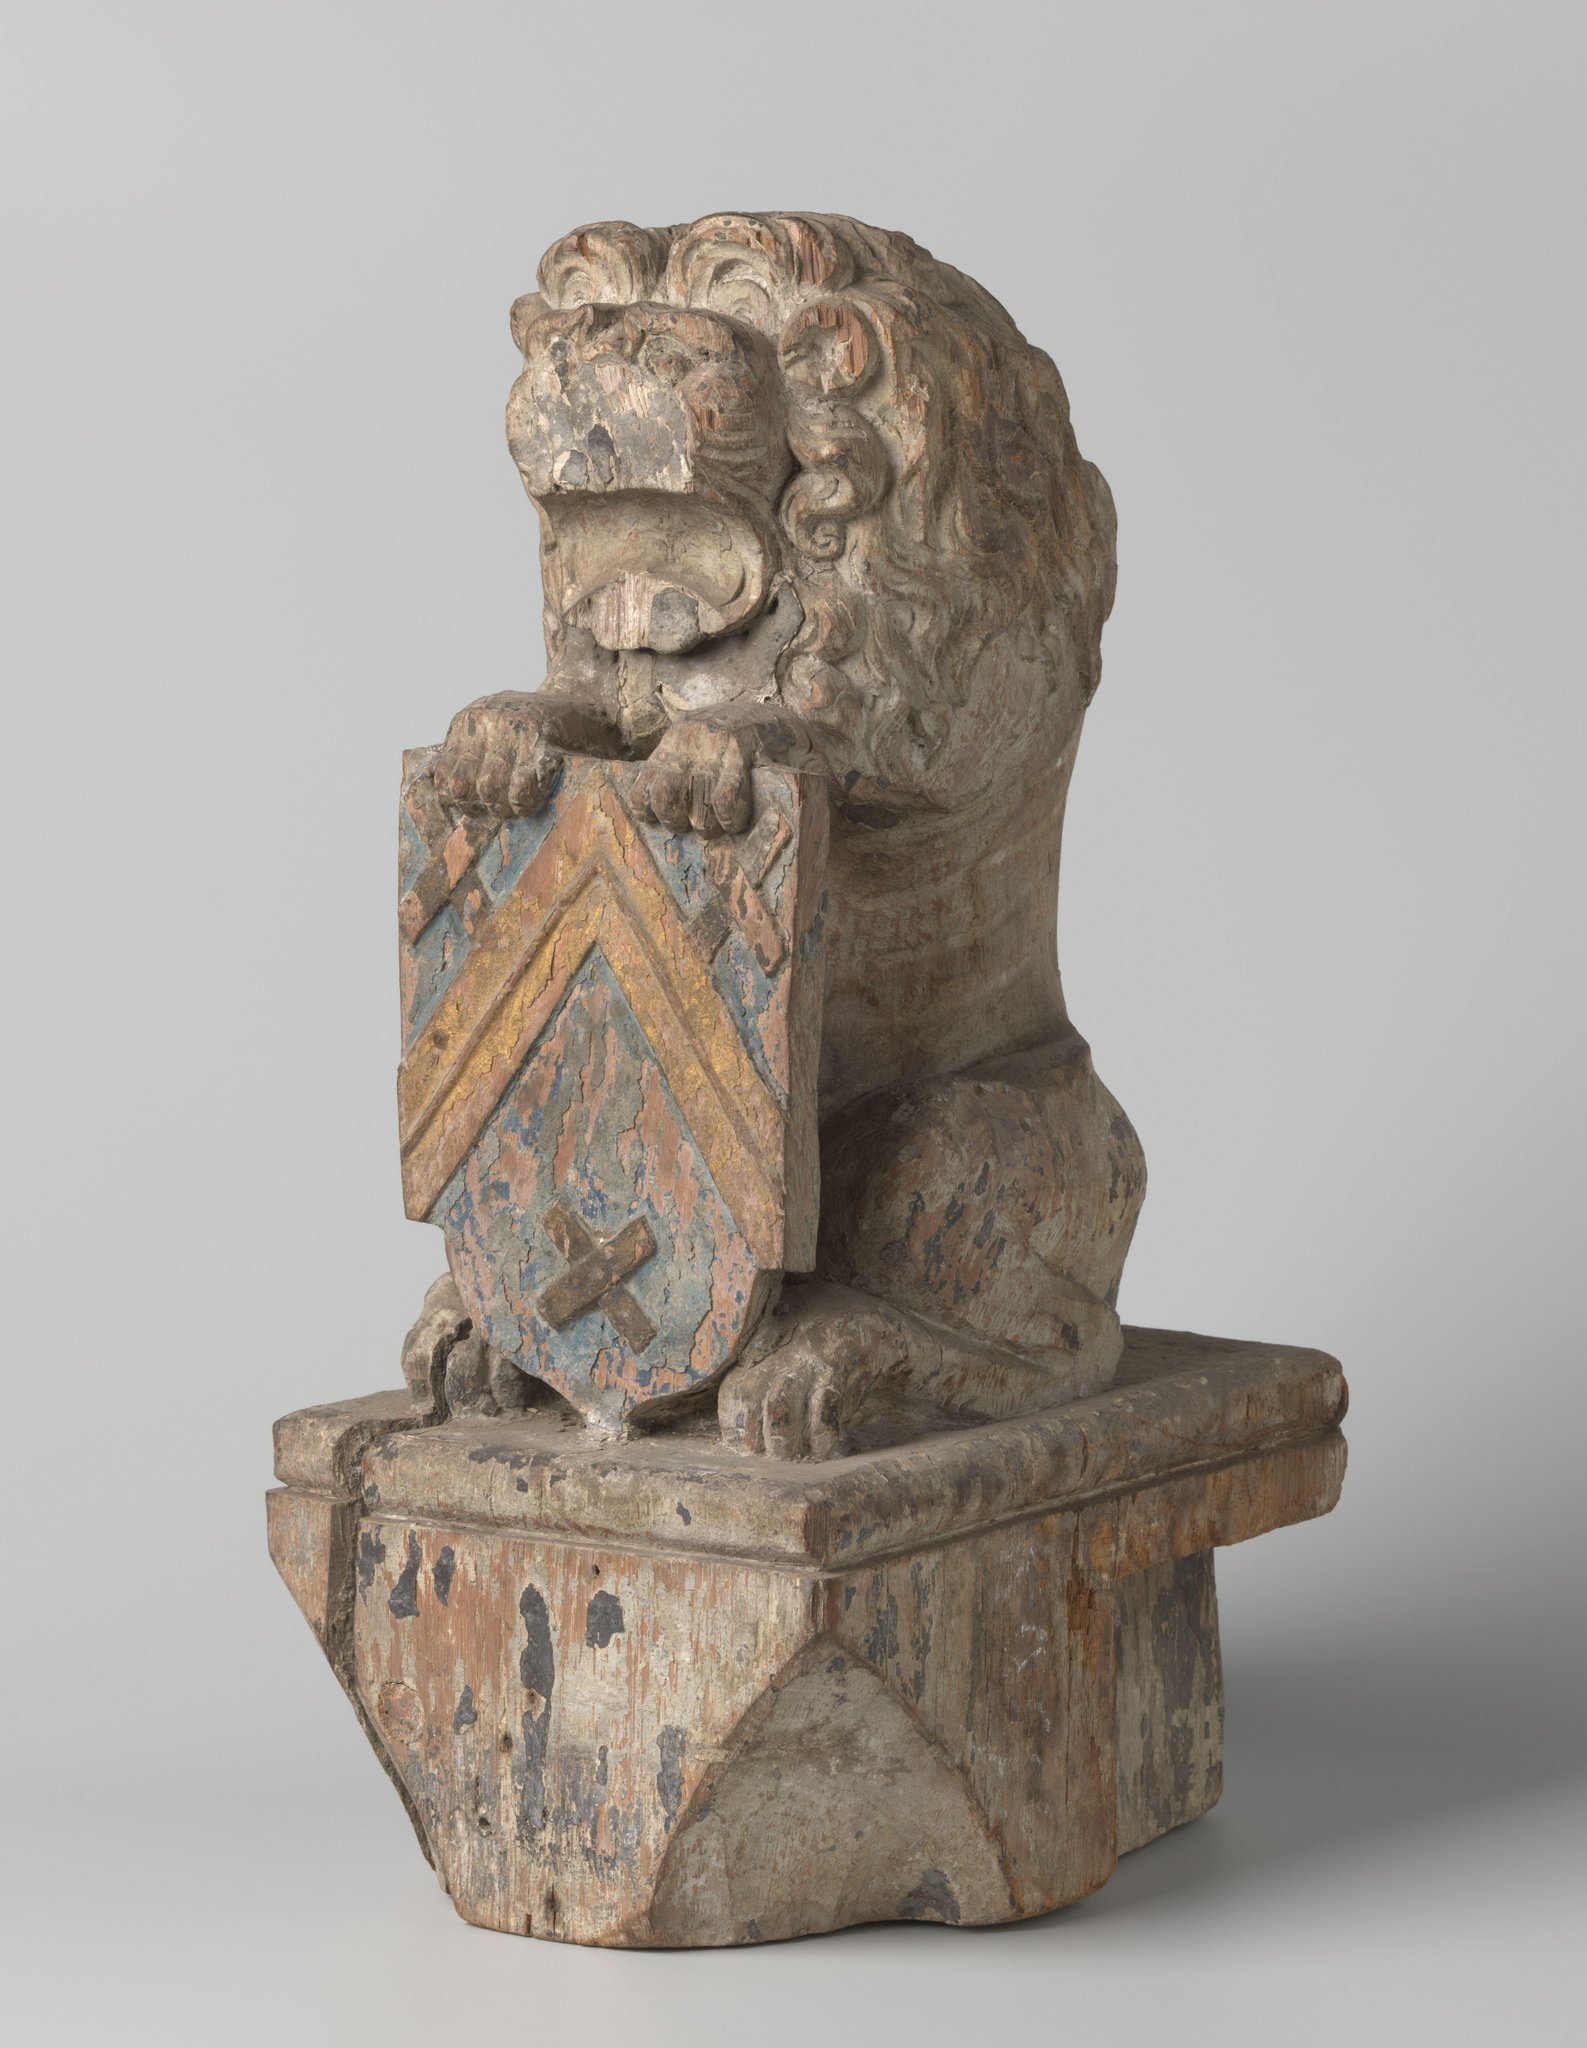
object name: schildhouder, schilddrager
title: Schilddrager in de vorm van een leeuw met wapenschild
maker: Anonymous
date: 1400-1950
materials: wood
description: Schilddrager van eikenhout in de vorm van een leeuw met wapenschild.Sporen van polychromie. Afkomstig van de balie van het door Karel de Stoute gestichte Hof van Holland op het binnenhof te 's-Gravenhage.